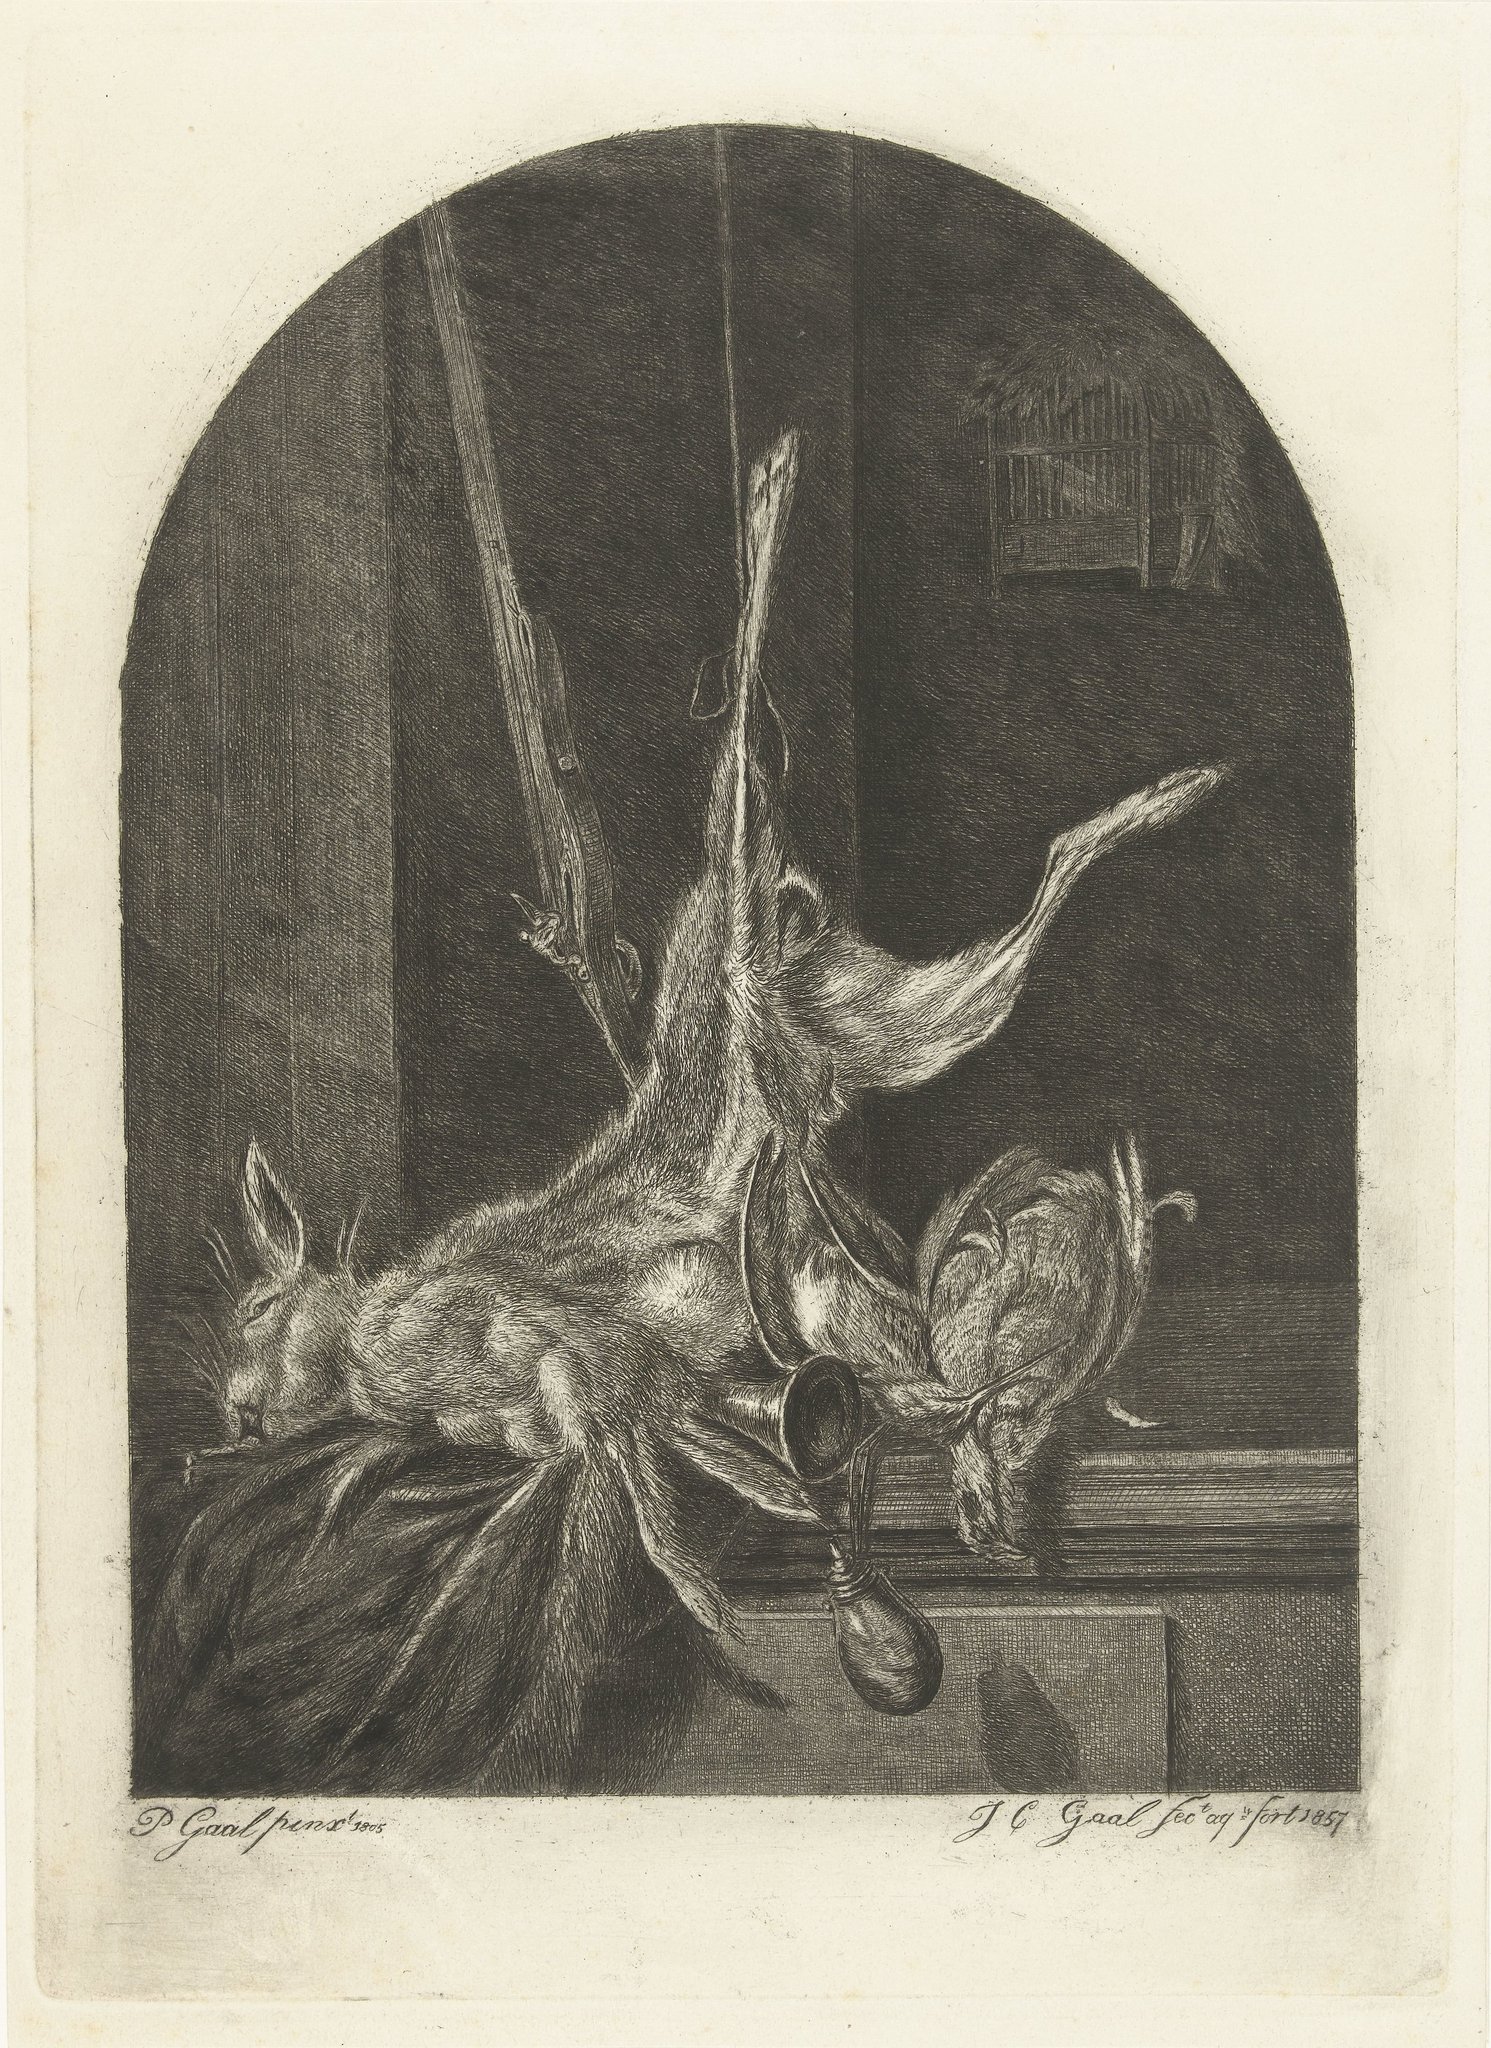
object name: print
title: Stilleven met dode haas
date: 1857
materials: paper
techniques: etching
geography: netherlands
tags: still life of miscellaneous objects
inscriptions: collector's mark: Lugt 2228